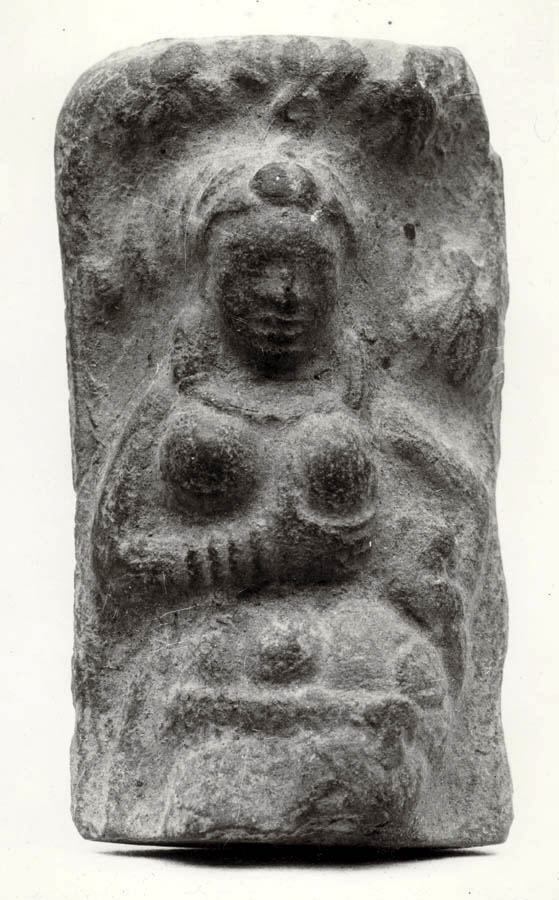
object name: relief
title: Relief of a Mother Goddess(?)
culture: indian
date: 1-200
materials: terracotta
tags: shunga,goddess